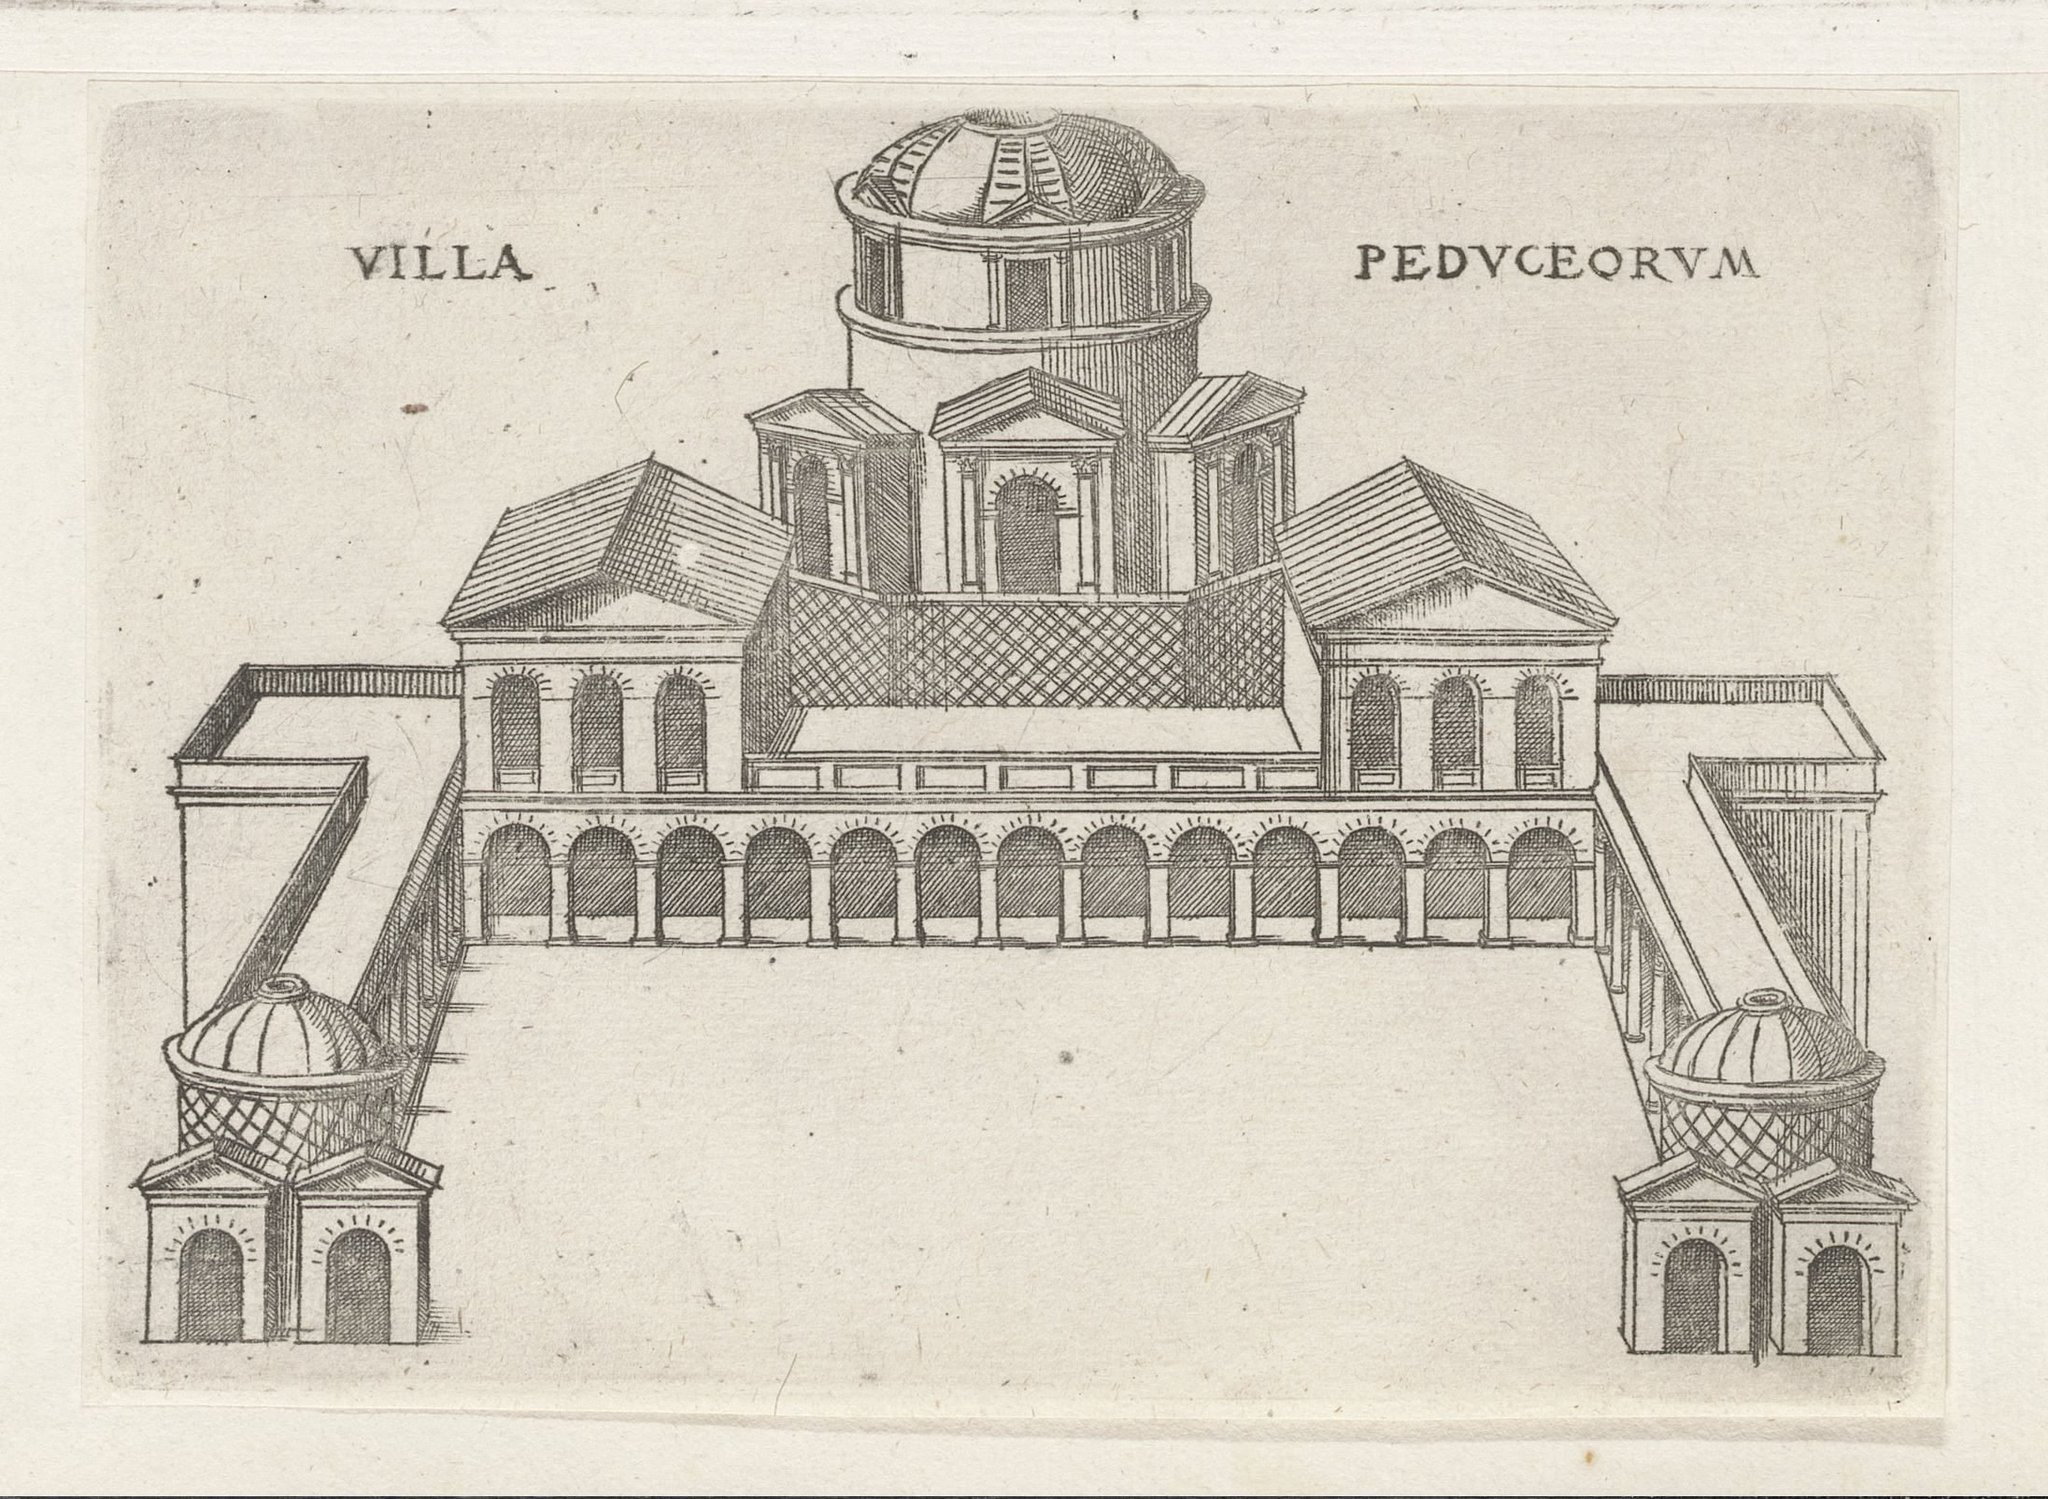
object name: album leaf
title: Villa Peduceorum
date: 1584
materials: paper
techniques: etching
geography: france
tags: villa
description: Deze prent maakt deel uit van een serie van 98 prenten gedrukt op 48 bladen. De bladen zijn verknipt en een selectie van de losse prenten is in dit album geplakt.